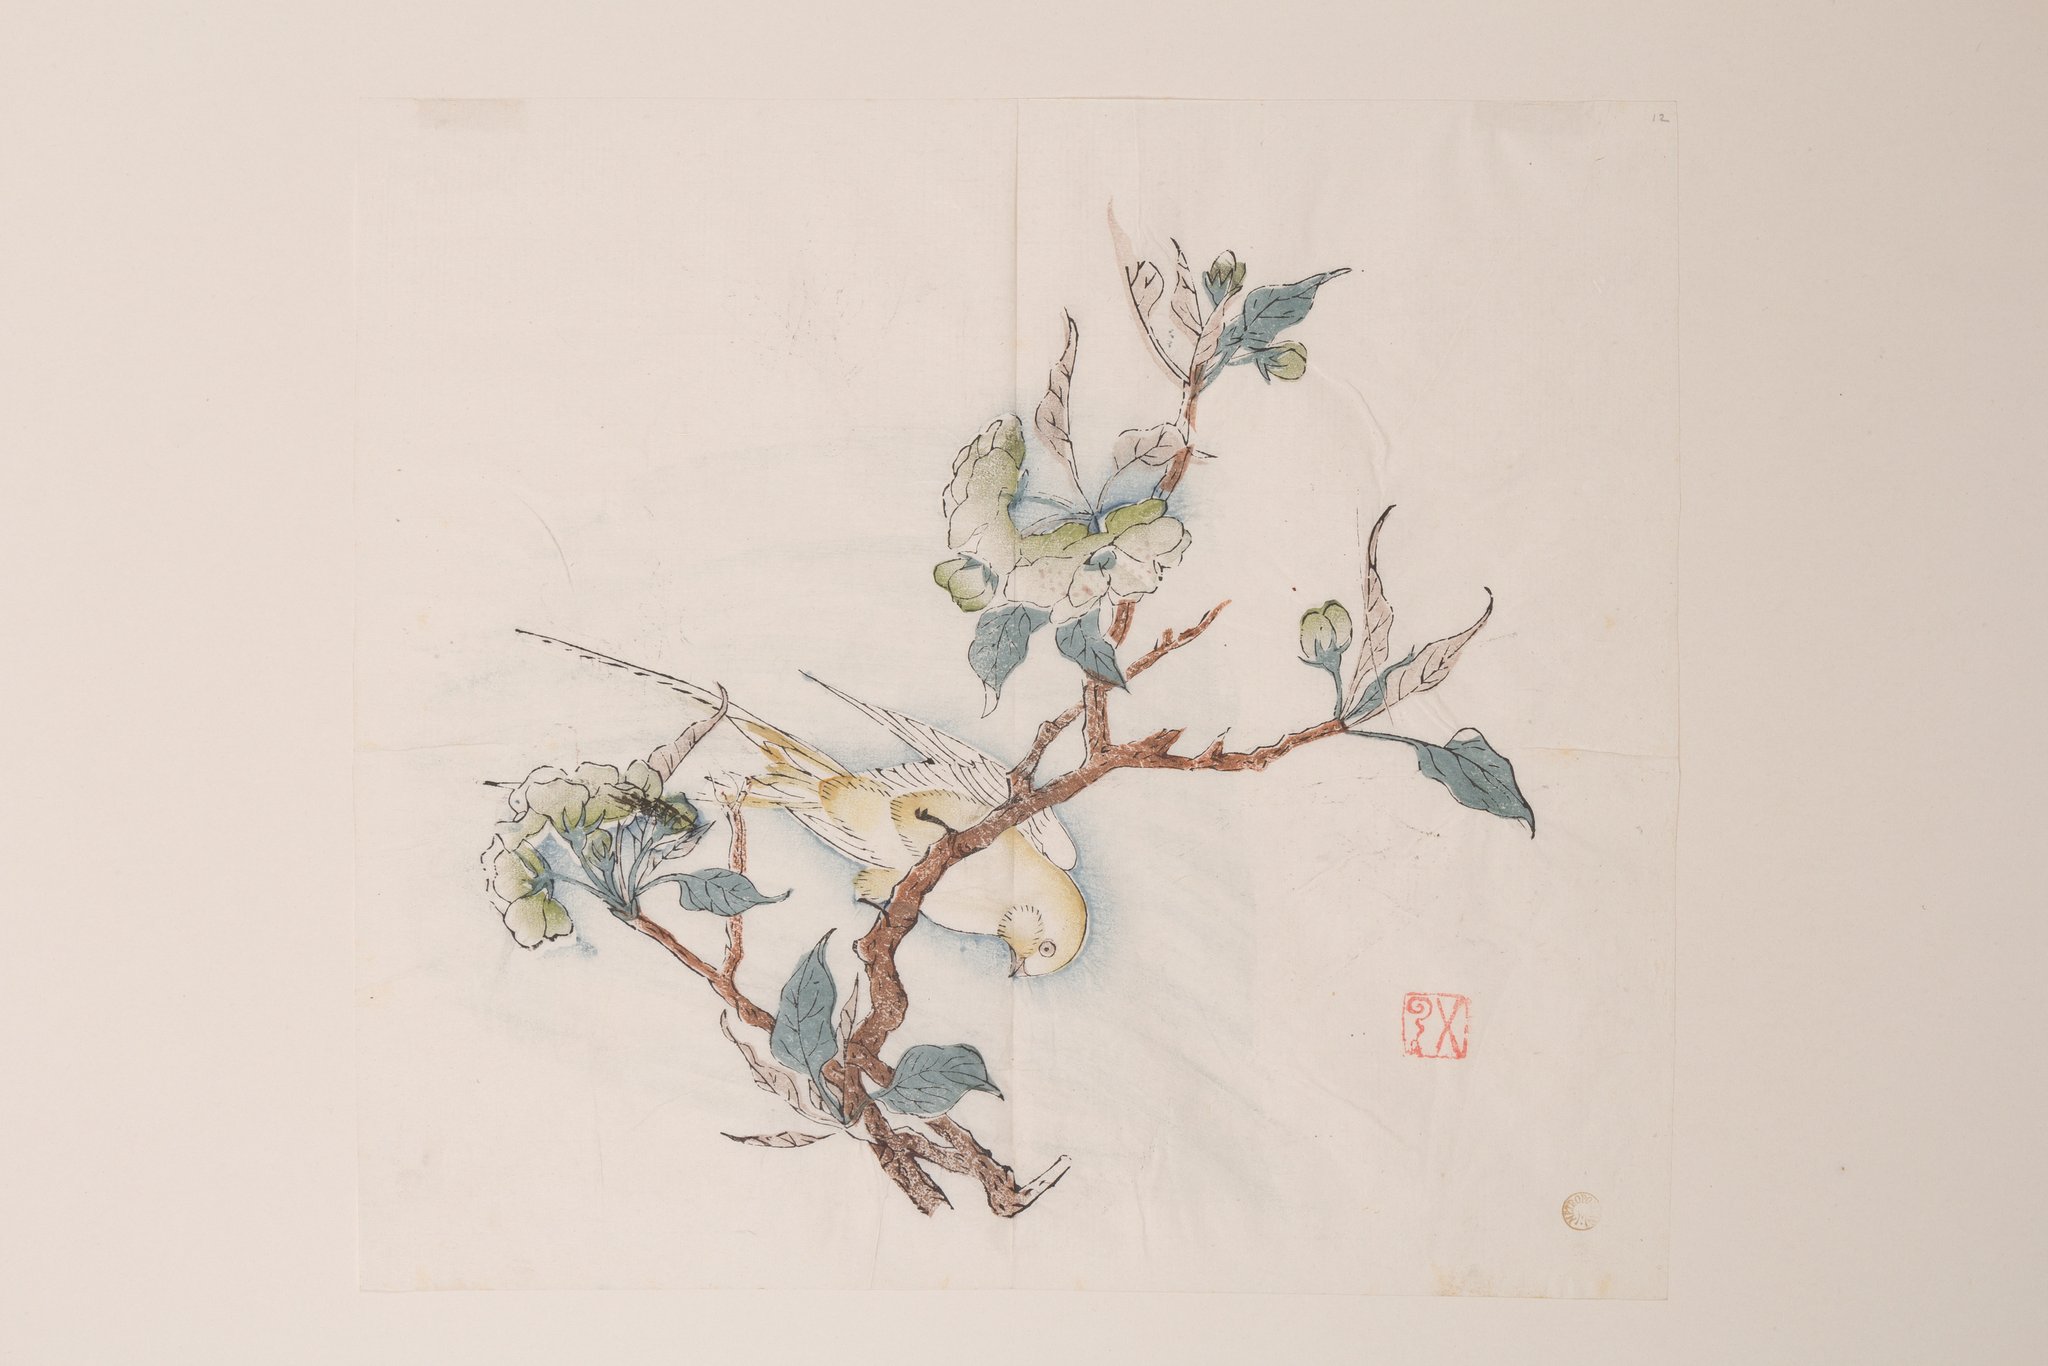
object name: print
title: Page from Shi Zhu Zhai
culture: chinese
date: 1736-1795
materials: ink, paper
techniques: polychrome, woodblock print